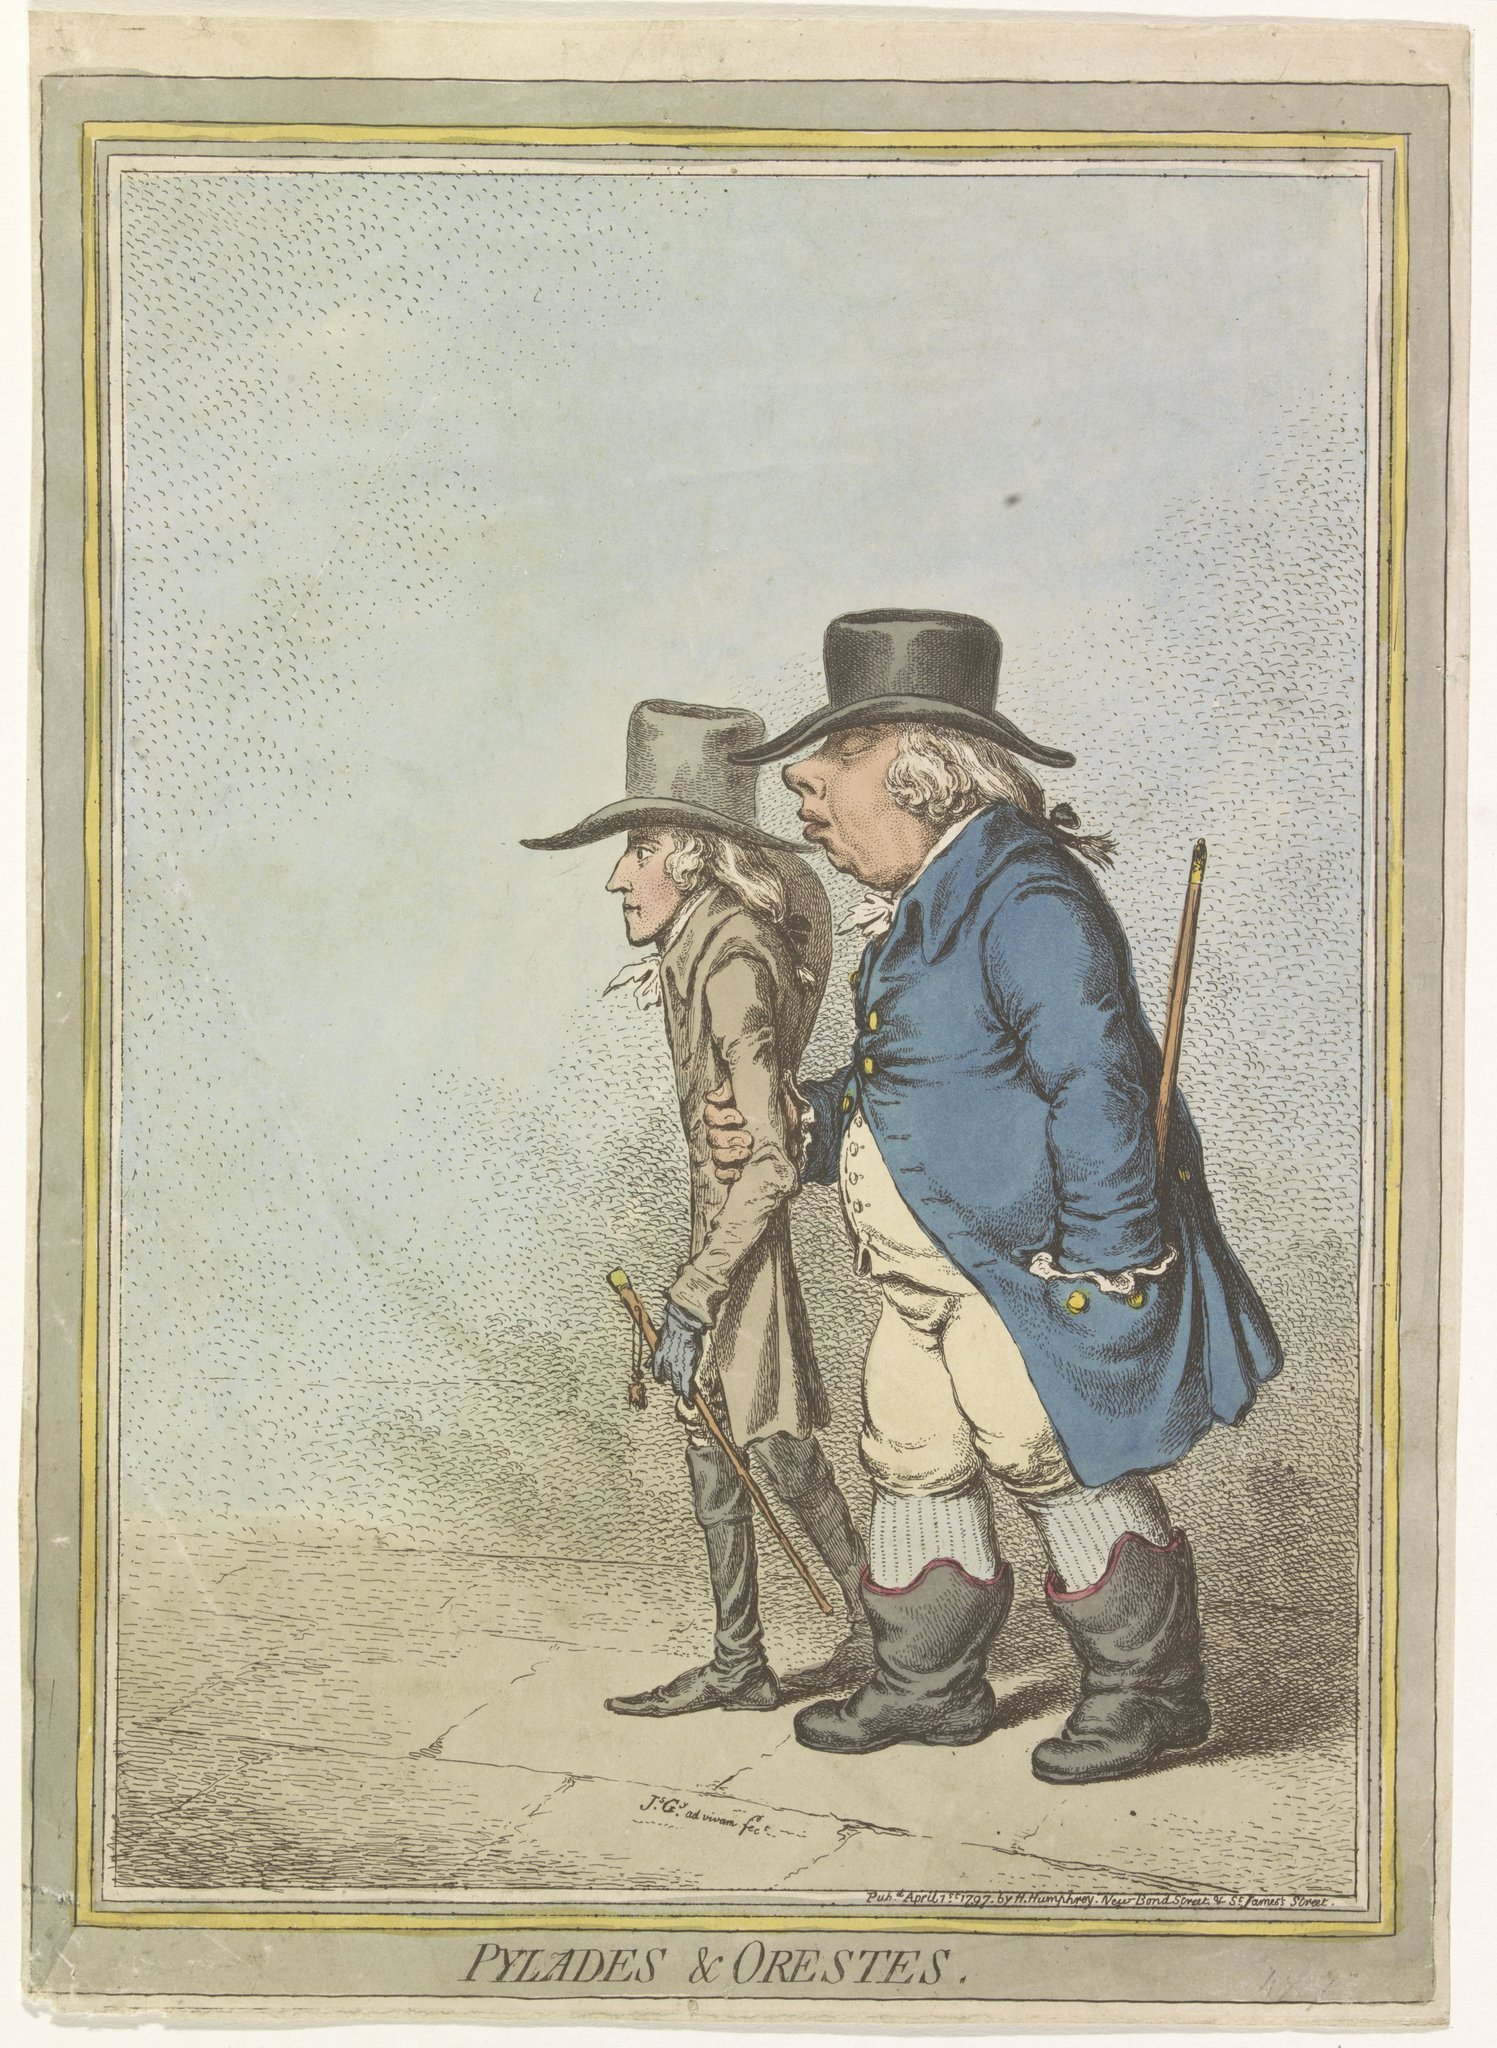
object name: cartoon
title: Pylades & Orestes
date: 1797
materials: paper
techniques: etching, hand coloring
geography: london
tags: the hague, william v (prince of orange), caricatures (human types), most important deeds: orestes avenging his father's death, political caricatures and satires, london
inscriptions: collector's mark: Lugt 2228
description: During his years in England, the stadtholder enjoyed going on sightseeing trips and walks. As his vision deteriorated over time, he was often escorted by his personal secretary, Count Nassalin. This odd couple were routinely spotted on their frequent strolls through London’s streets. The title Pylades & Orestes refers to two inseparable friends from Greek myth.